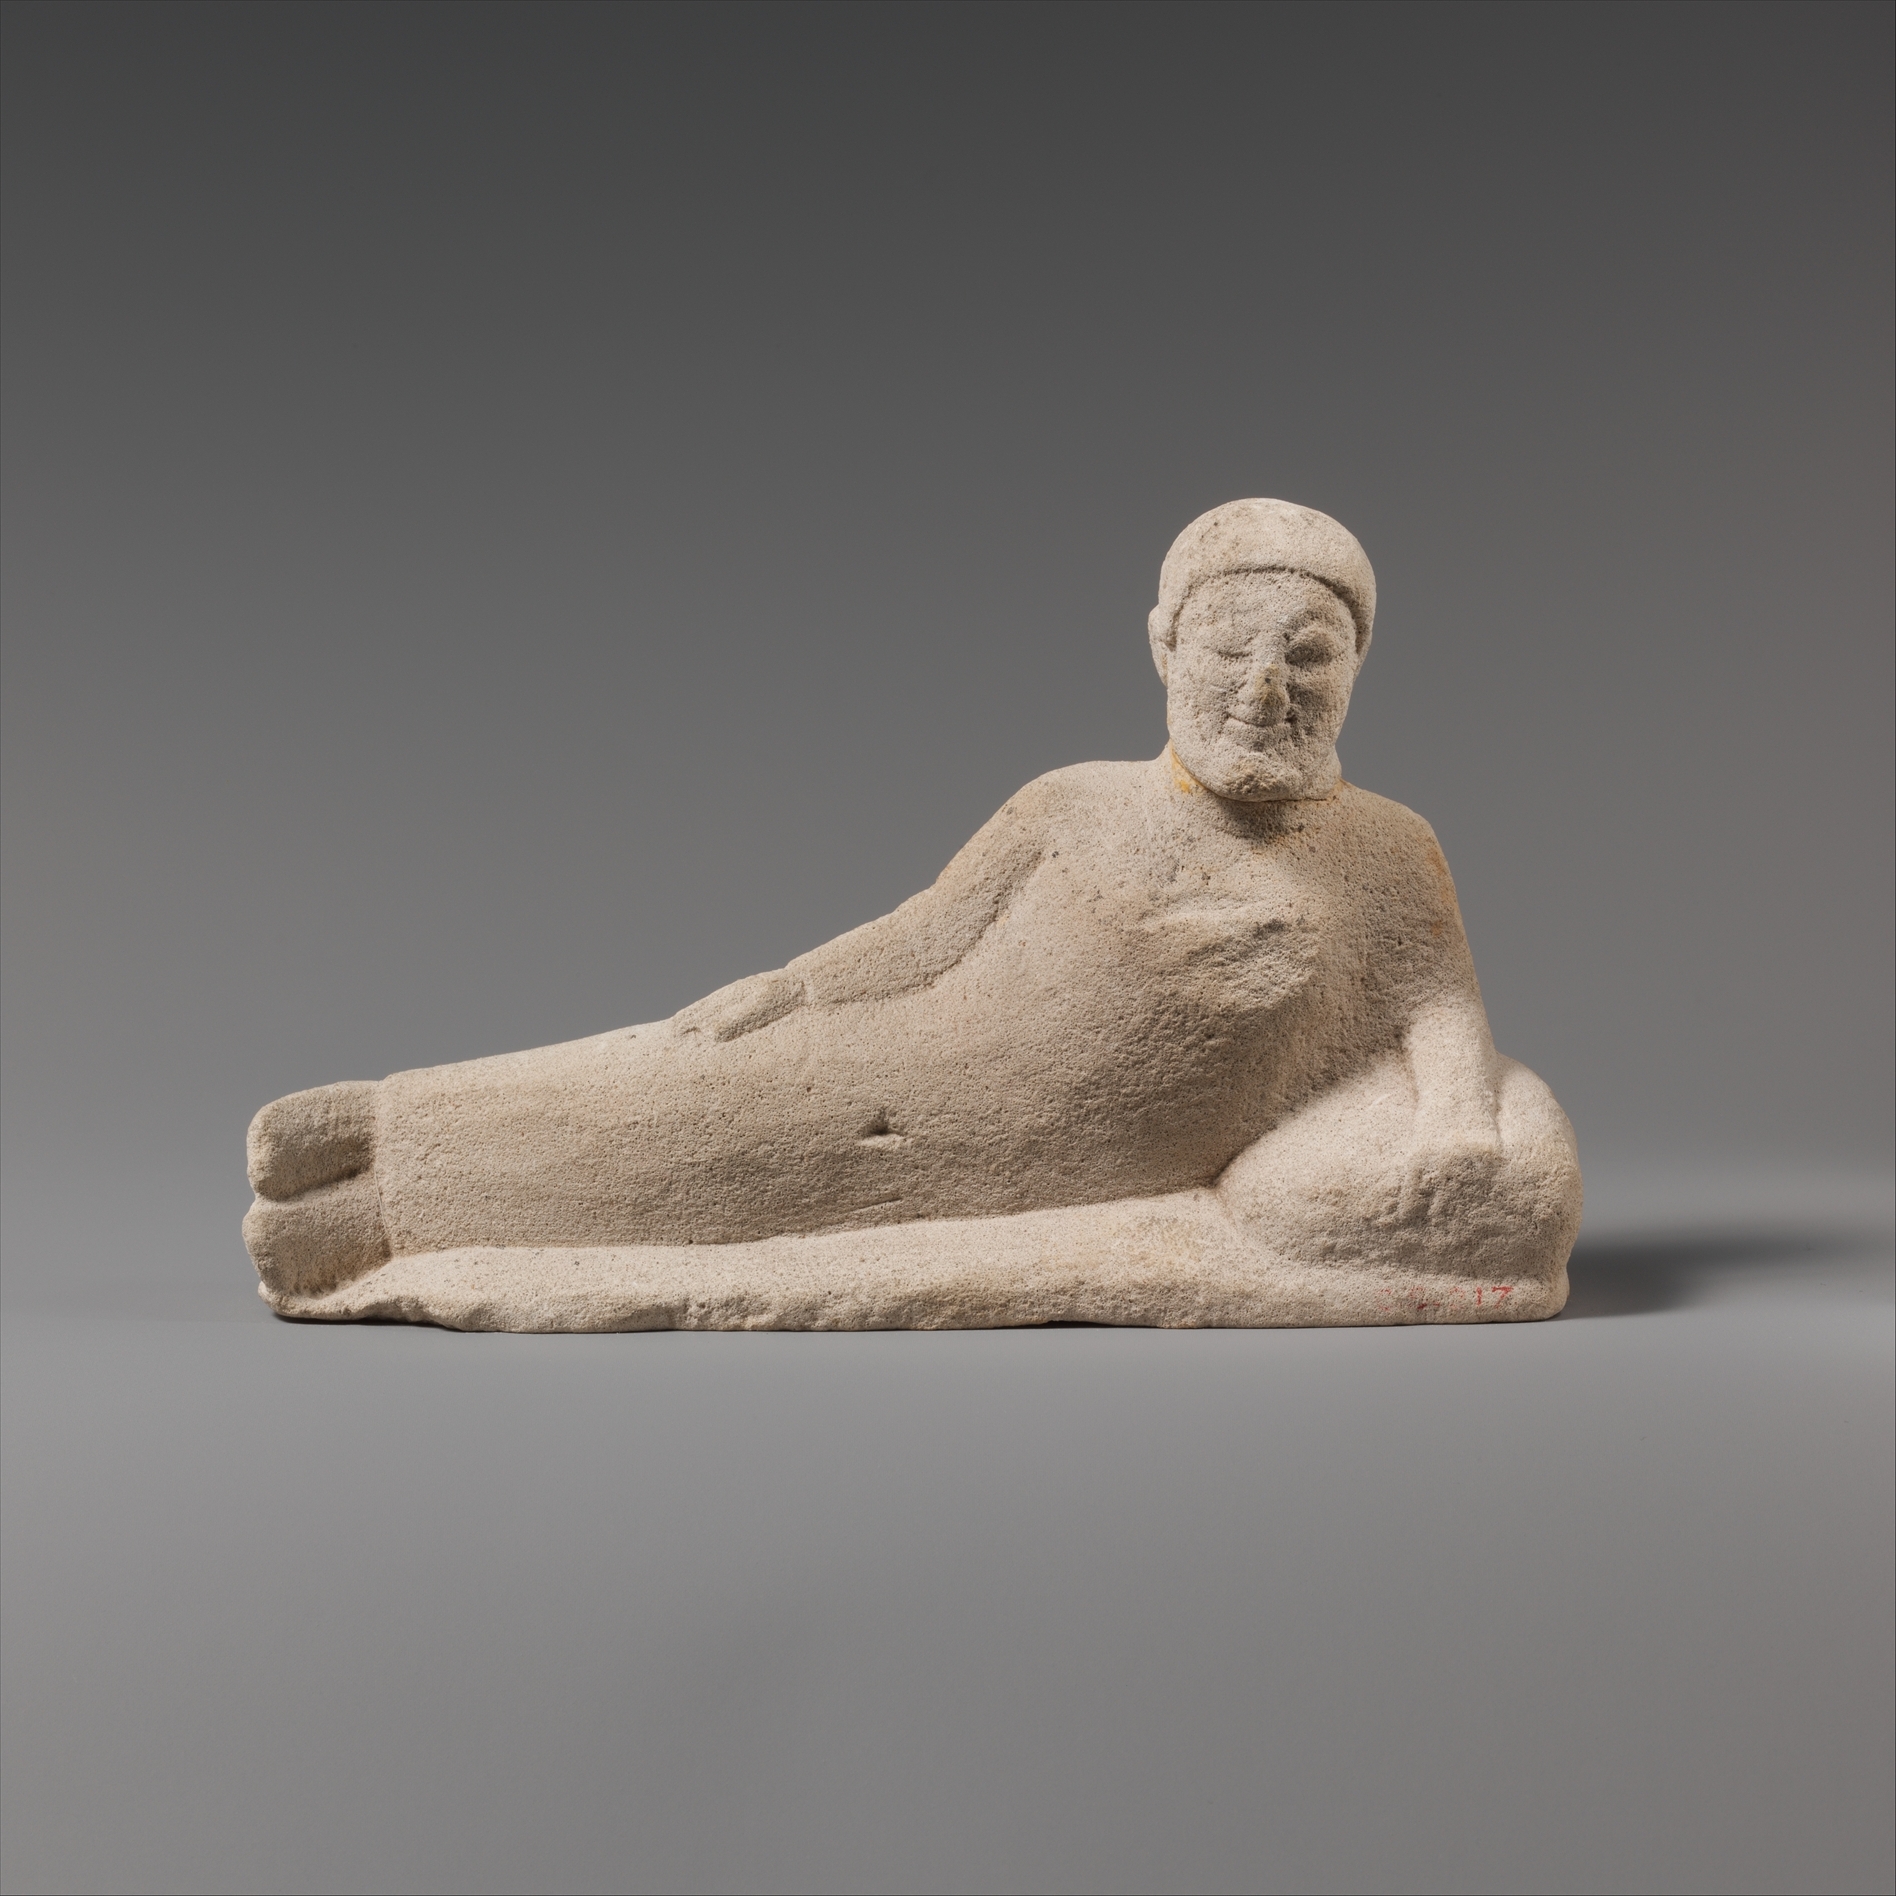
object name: statue of a votary, male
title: Limestone statuette of a reclining banqueter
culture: cypriot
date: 550-501 BCE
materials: limestone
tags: men